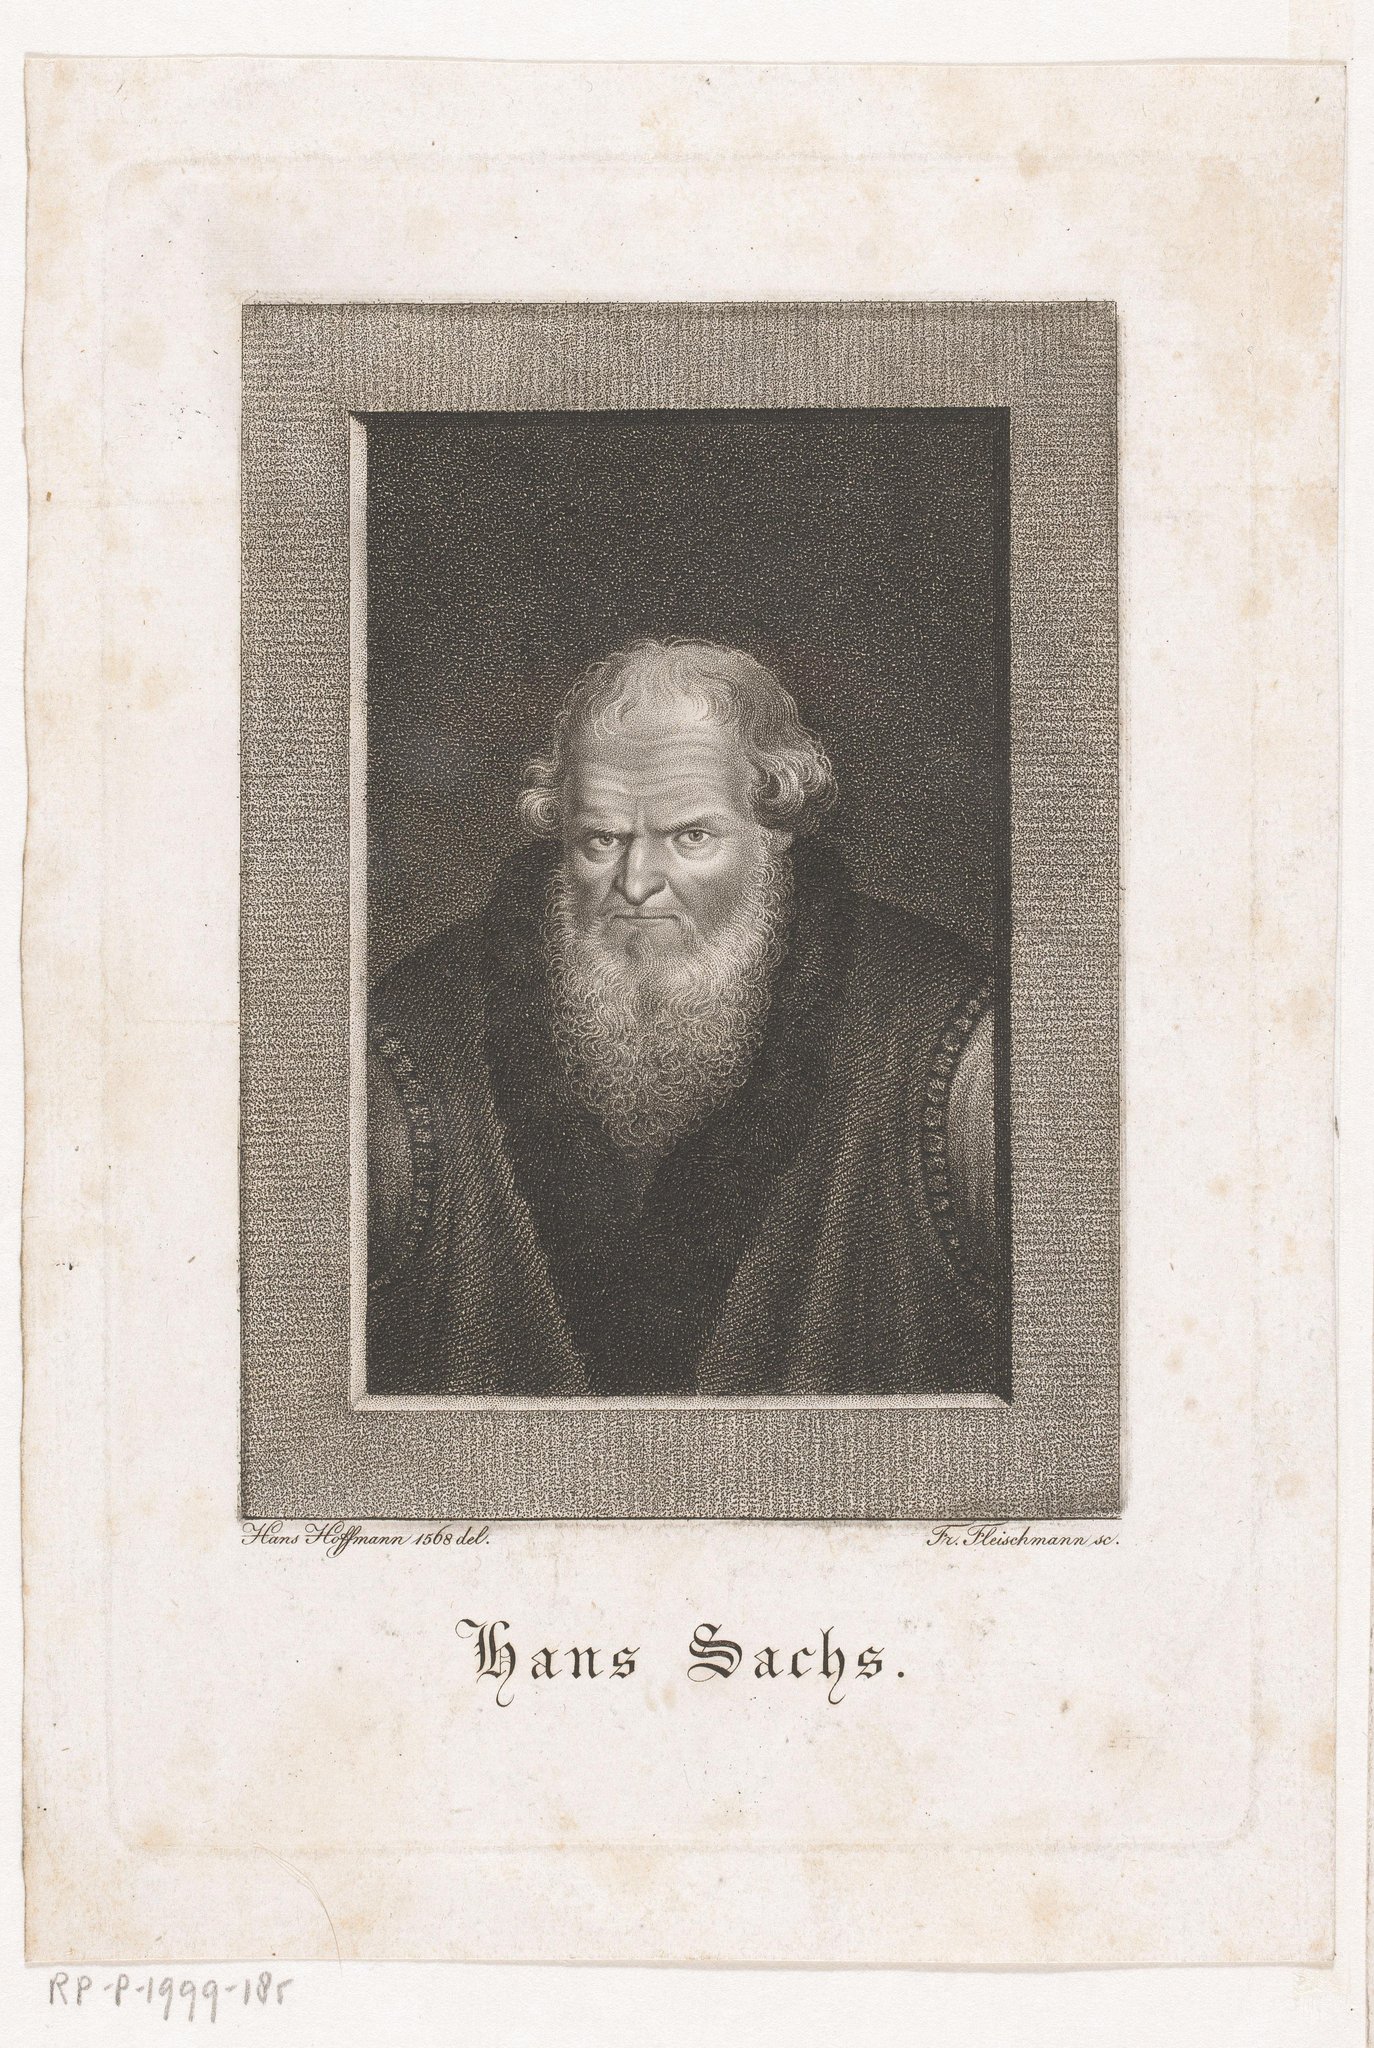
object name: print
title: Portret van Hans Sachs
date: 1801-1834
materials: paper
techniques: stippling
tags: hans sachs, historical persons, writer, poet, author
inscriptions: collector's mark: Lugt 2228, collector's mark: Lugt 4100, collector's mark: Lugt 2760